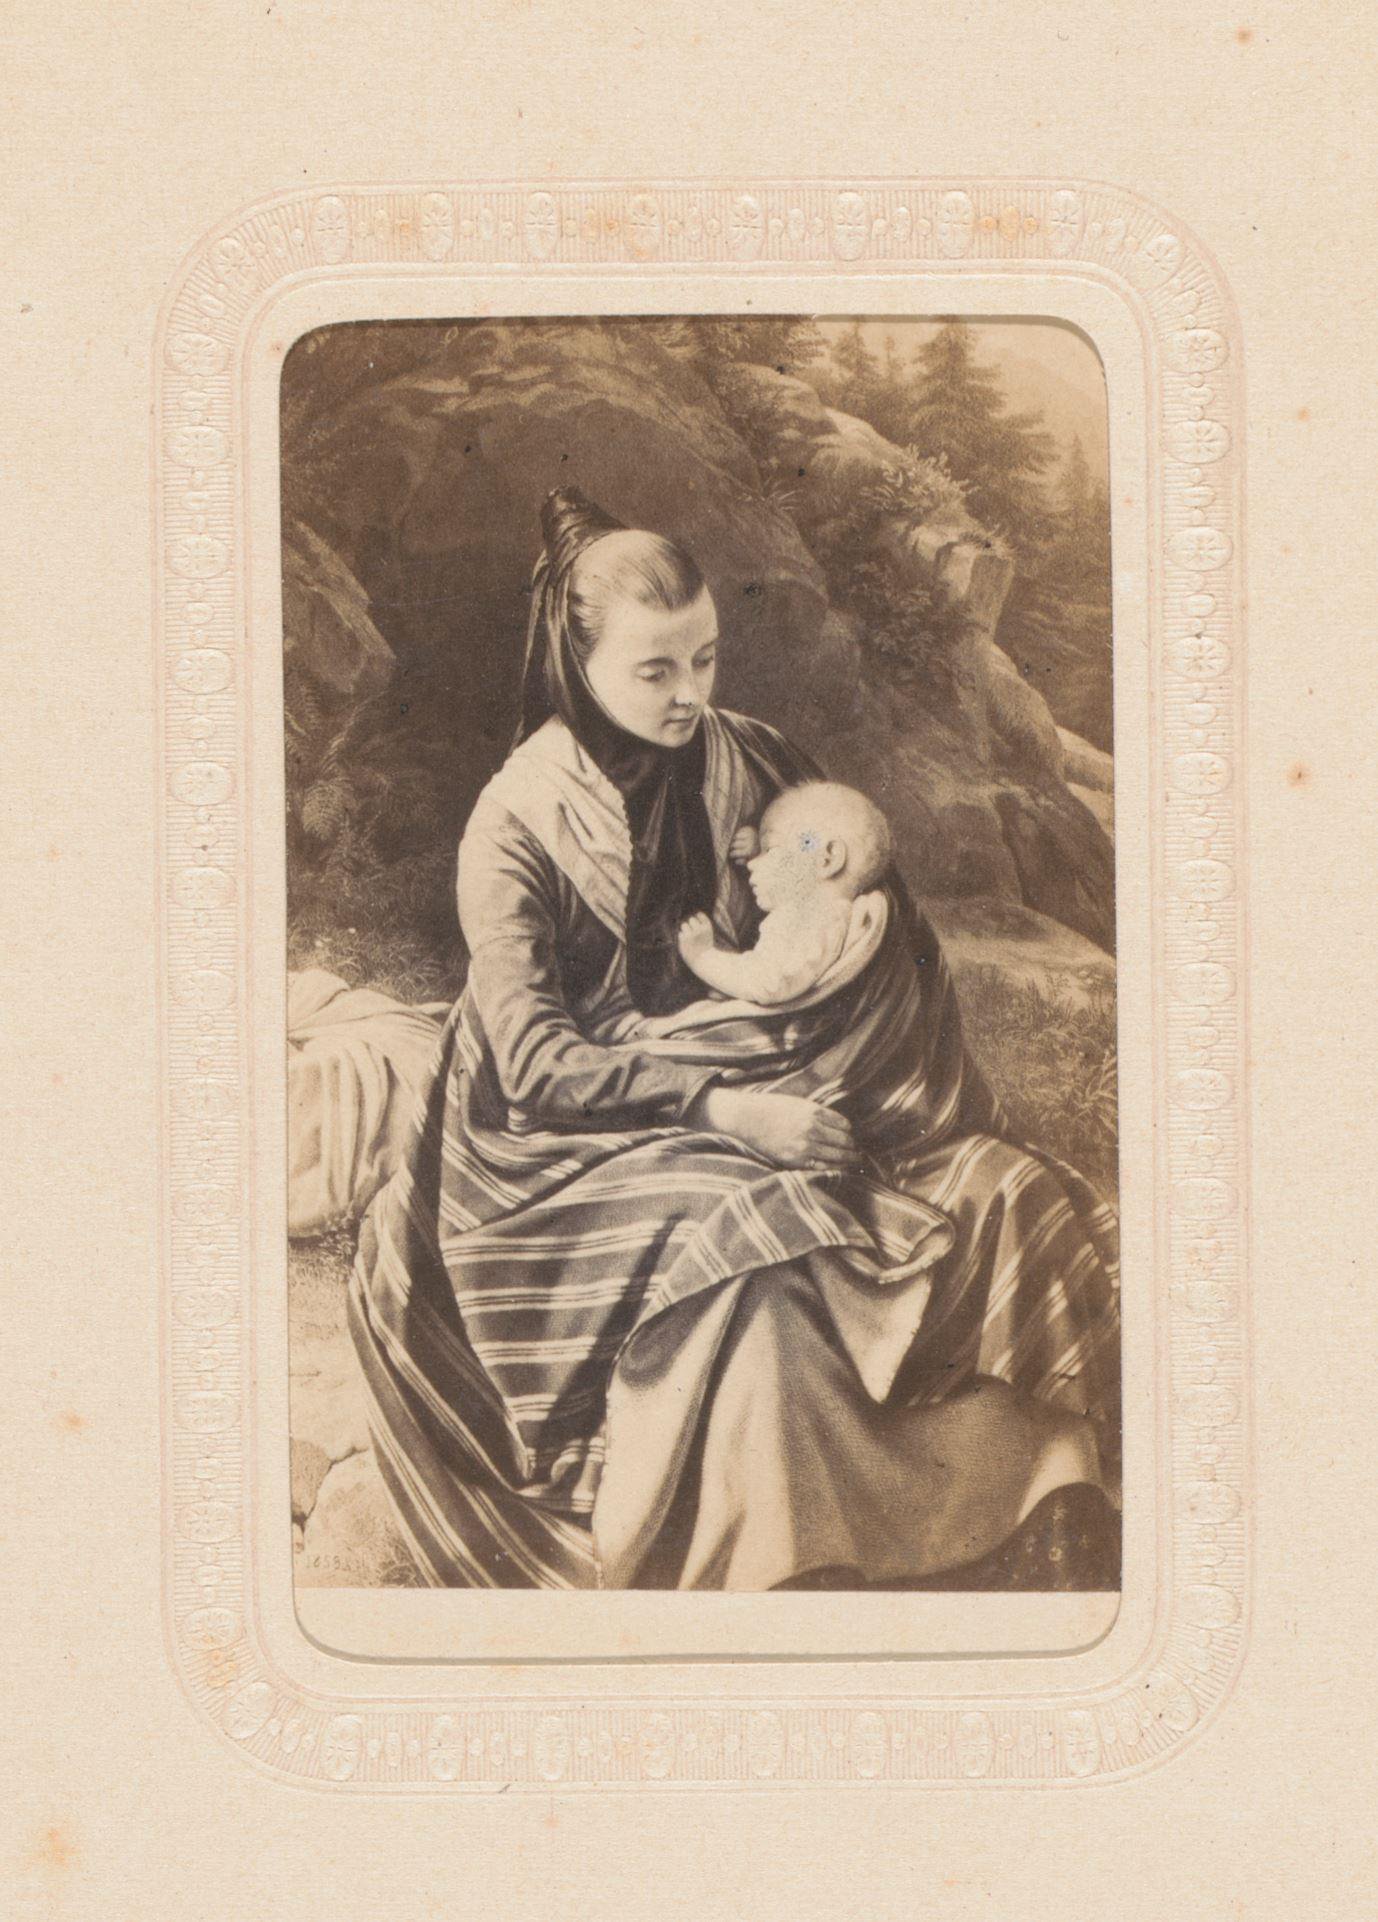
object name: photograph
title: Fotoreproductie van een schilderij met een moeder met kind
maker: Anonymous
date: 1855-1865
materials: cardboard, photographic support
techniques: albumen print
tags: mother and baby or young child